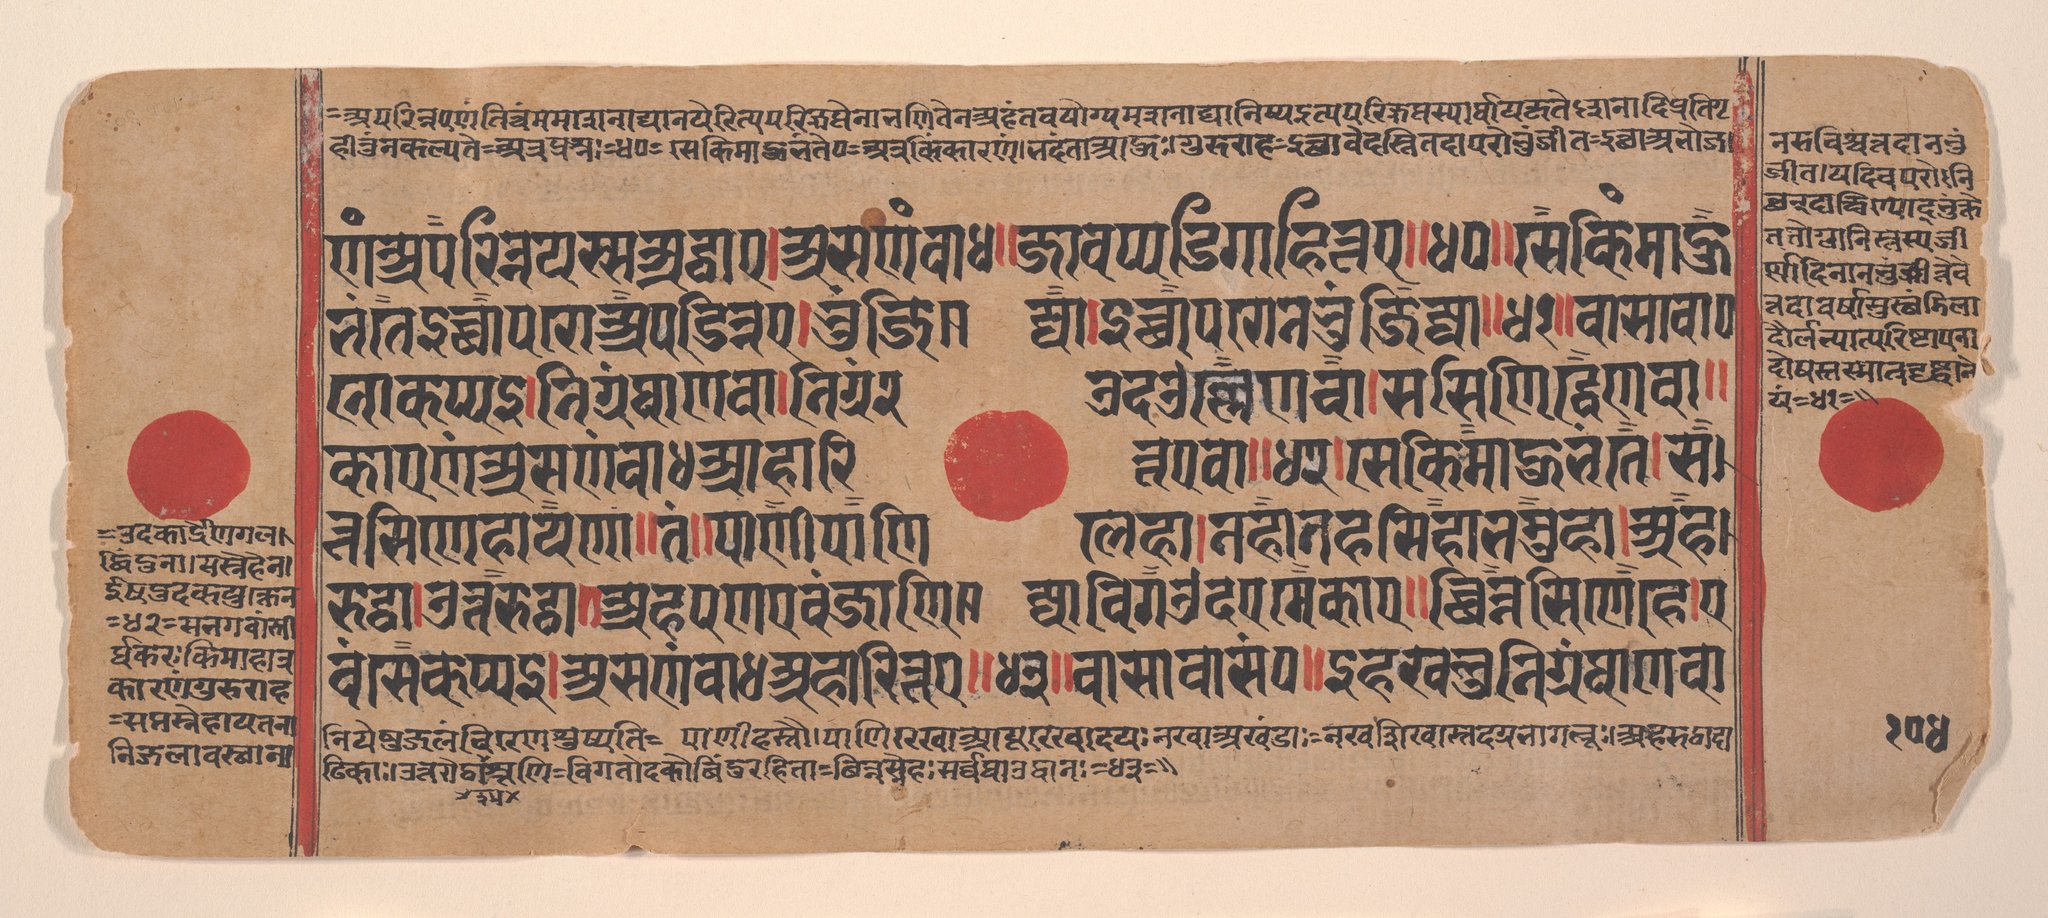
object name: folio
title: Page from a Dispersed Kalpa Sutra (Jain Book of Rituals)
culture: indian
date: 1401-1500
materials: gold, ink, paper, watercolor